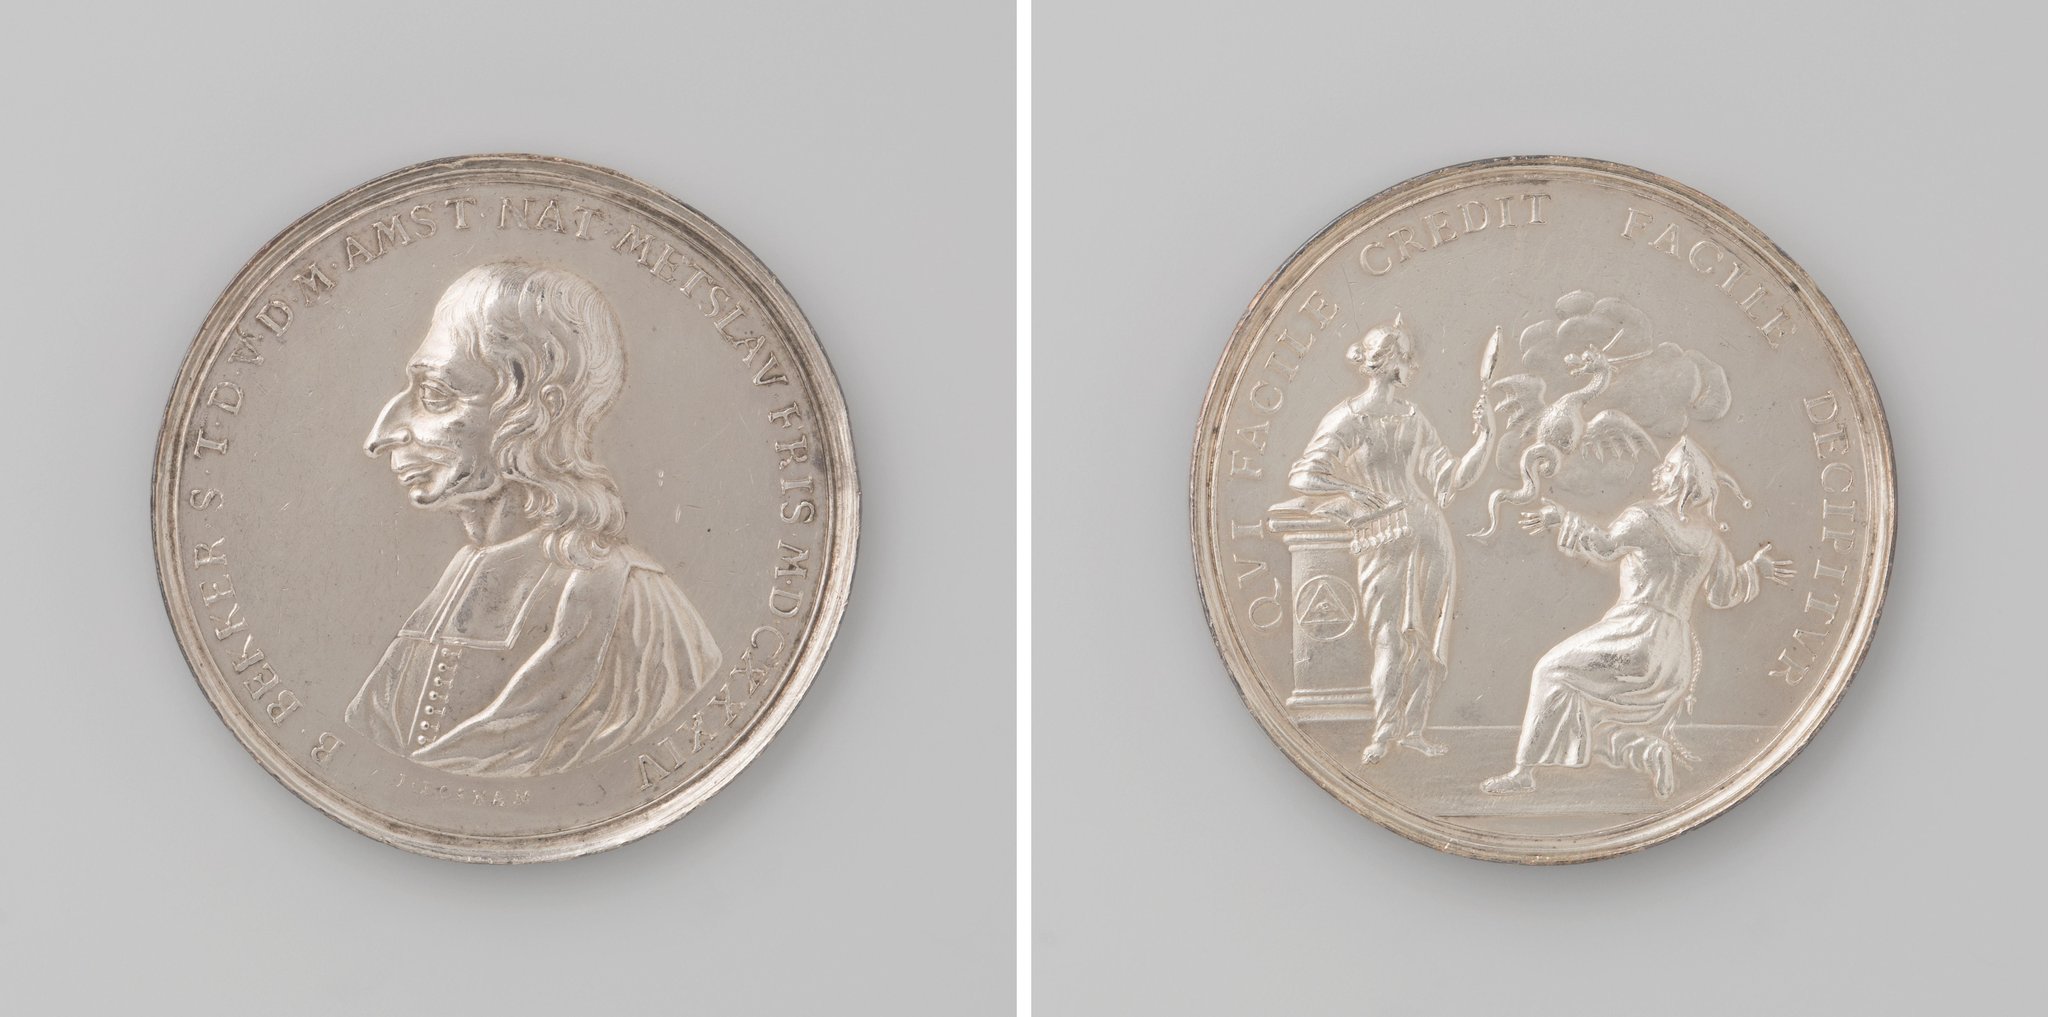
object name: satirical medal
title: Balthasar Bekker, predikant te Amsterdam, door de synode van Alkmaar afgezet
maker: jan boskam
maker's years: 1687-1708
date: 1692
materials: silver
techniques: striking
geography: nijmegen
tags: amsterdam, balthasar bekker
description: Zilveren penning. Voorzijde: borststuk man binnen omschrift. Keerzijde: vrouw met spiegel leunend op geopend boek dat op zuil ligt en nar die schrikt van een gevleugelde draak in een wolk binnen omschrift